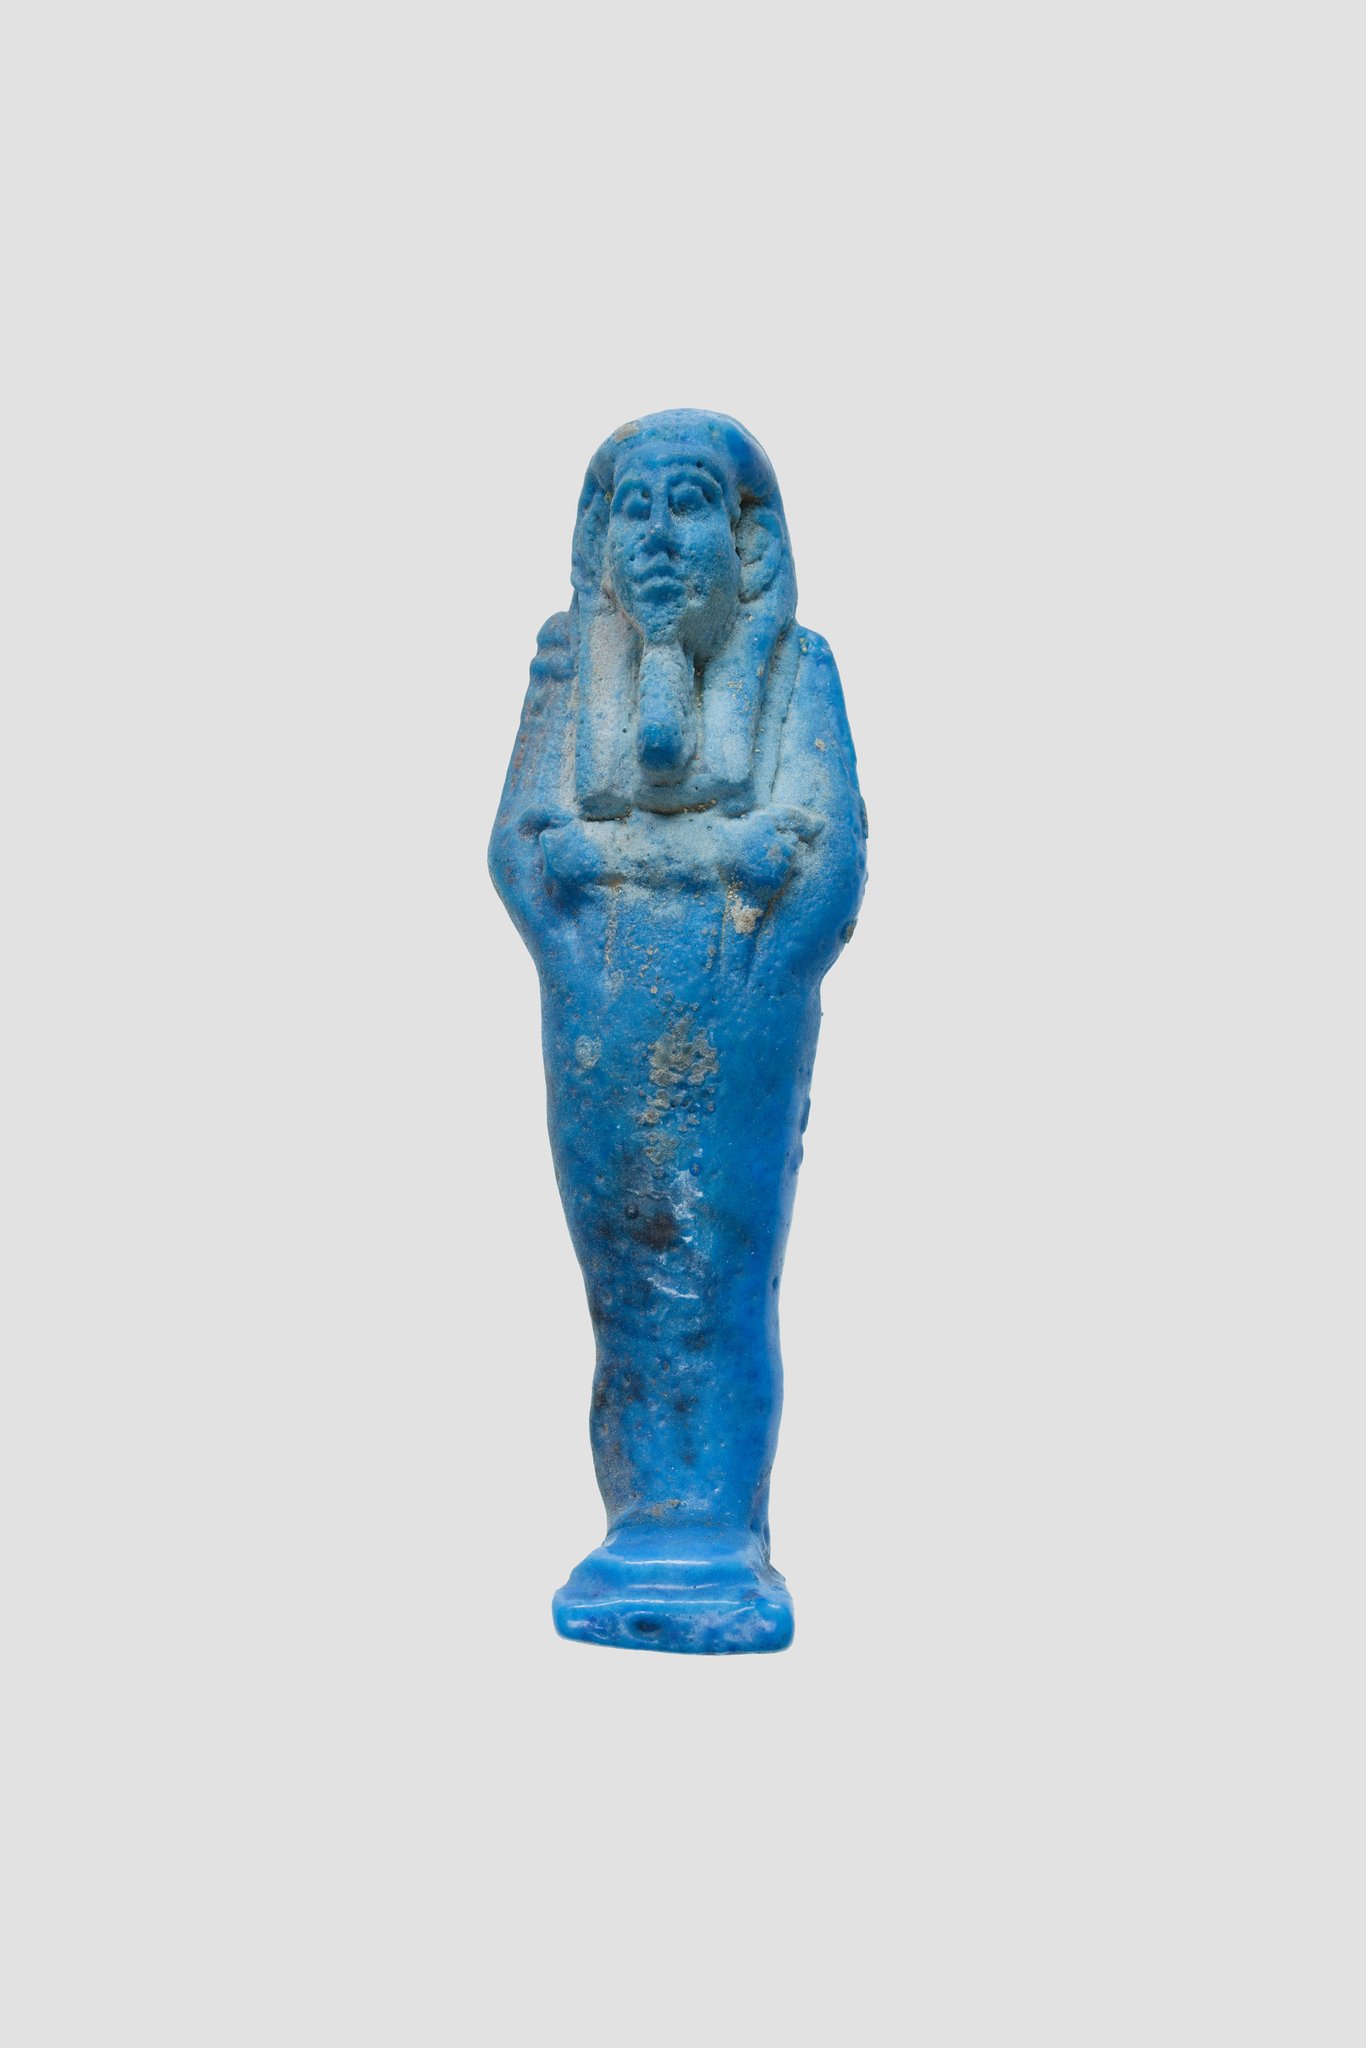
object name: shabti, nespekashuty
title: Uninscribed shabti from tomb of Nespekashuty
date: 664-610 BCE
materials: faience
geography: egypt